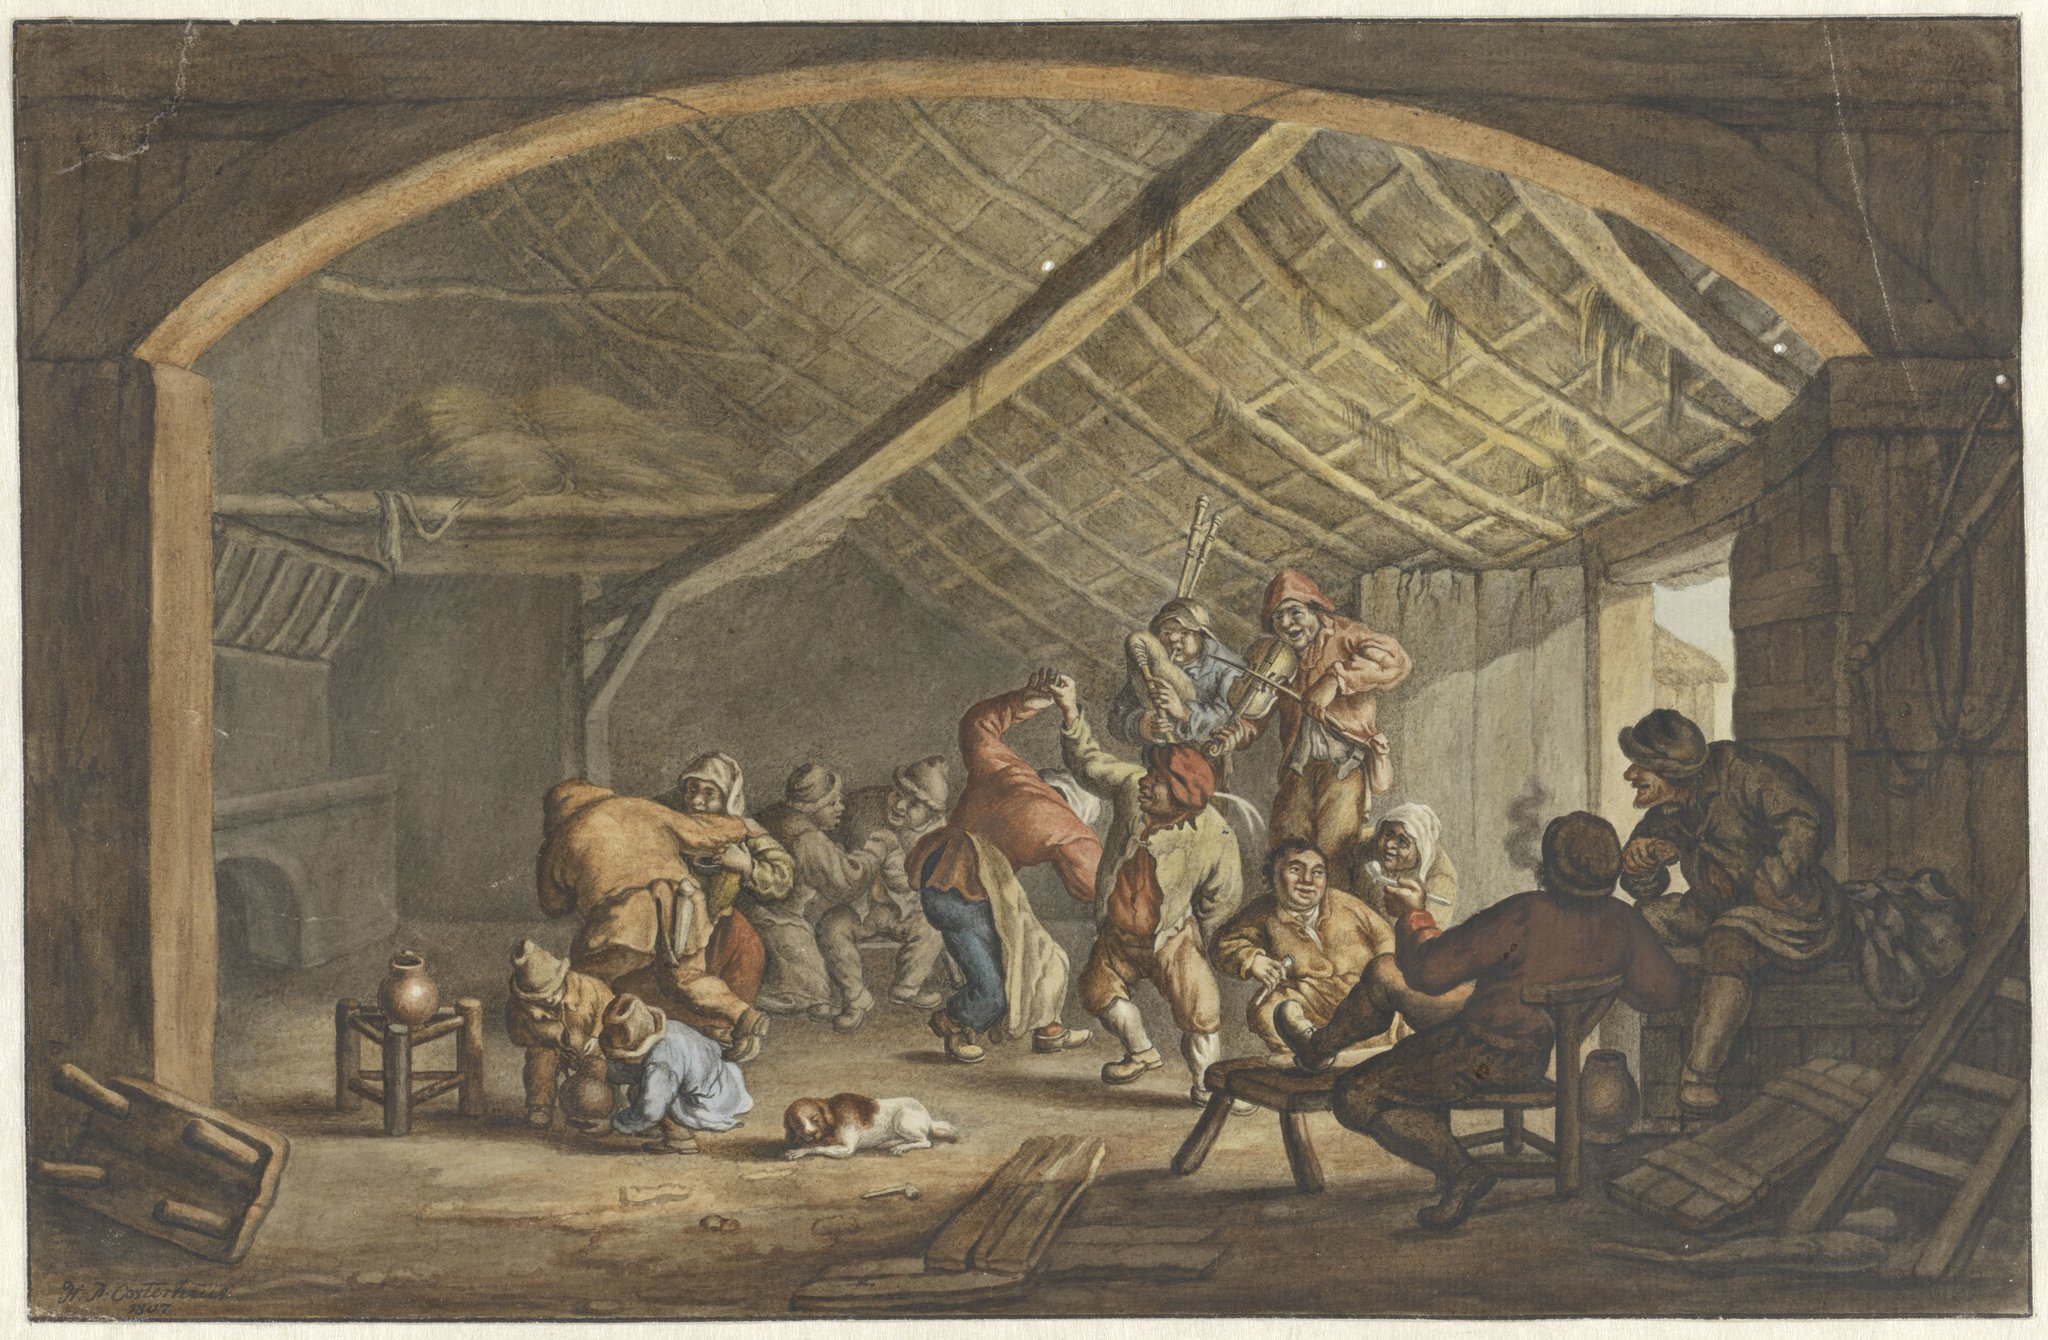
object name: watercolor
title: Herberginterieur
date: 1807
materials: paper, watercolor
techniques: brush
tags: dancing, inn, coffee-house, public house, etc.